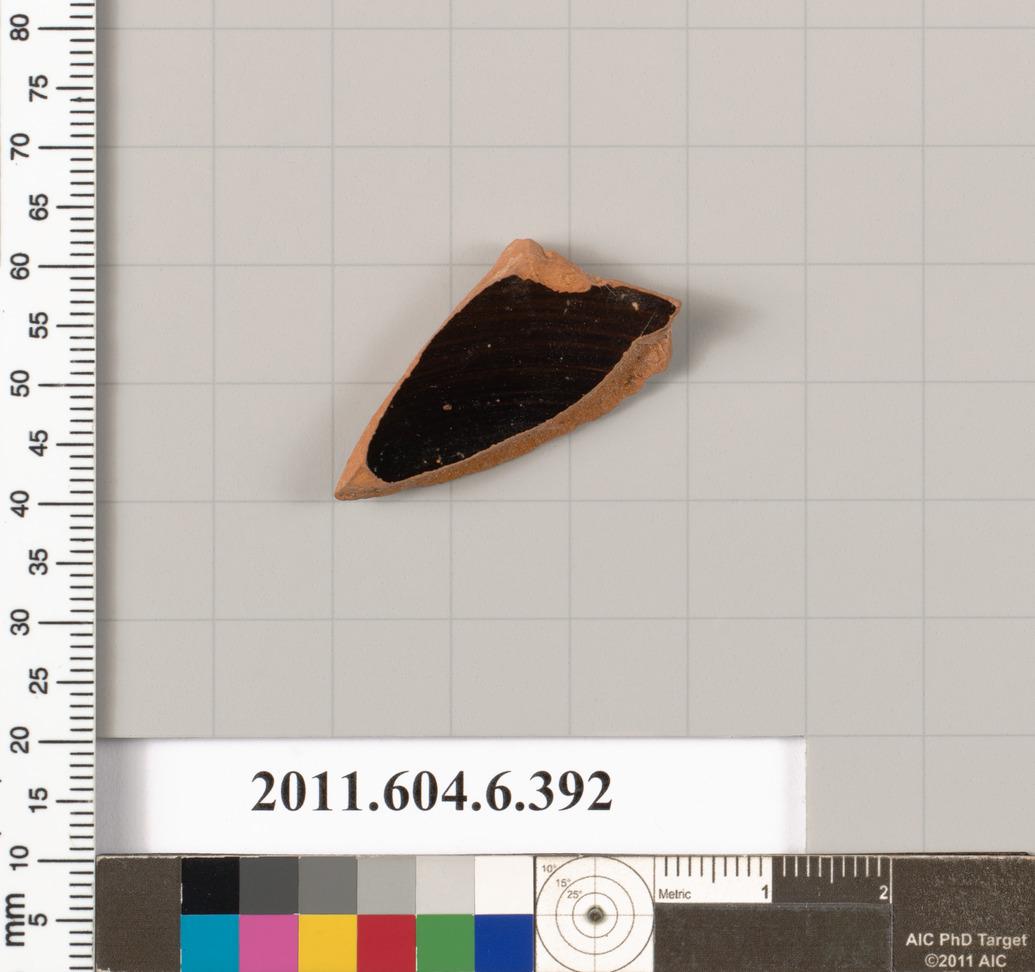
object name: undetermined open shape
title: Terracotta fragment of an open shape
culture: greek, attic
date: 600-401 BCE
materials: terracotta